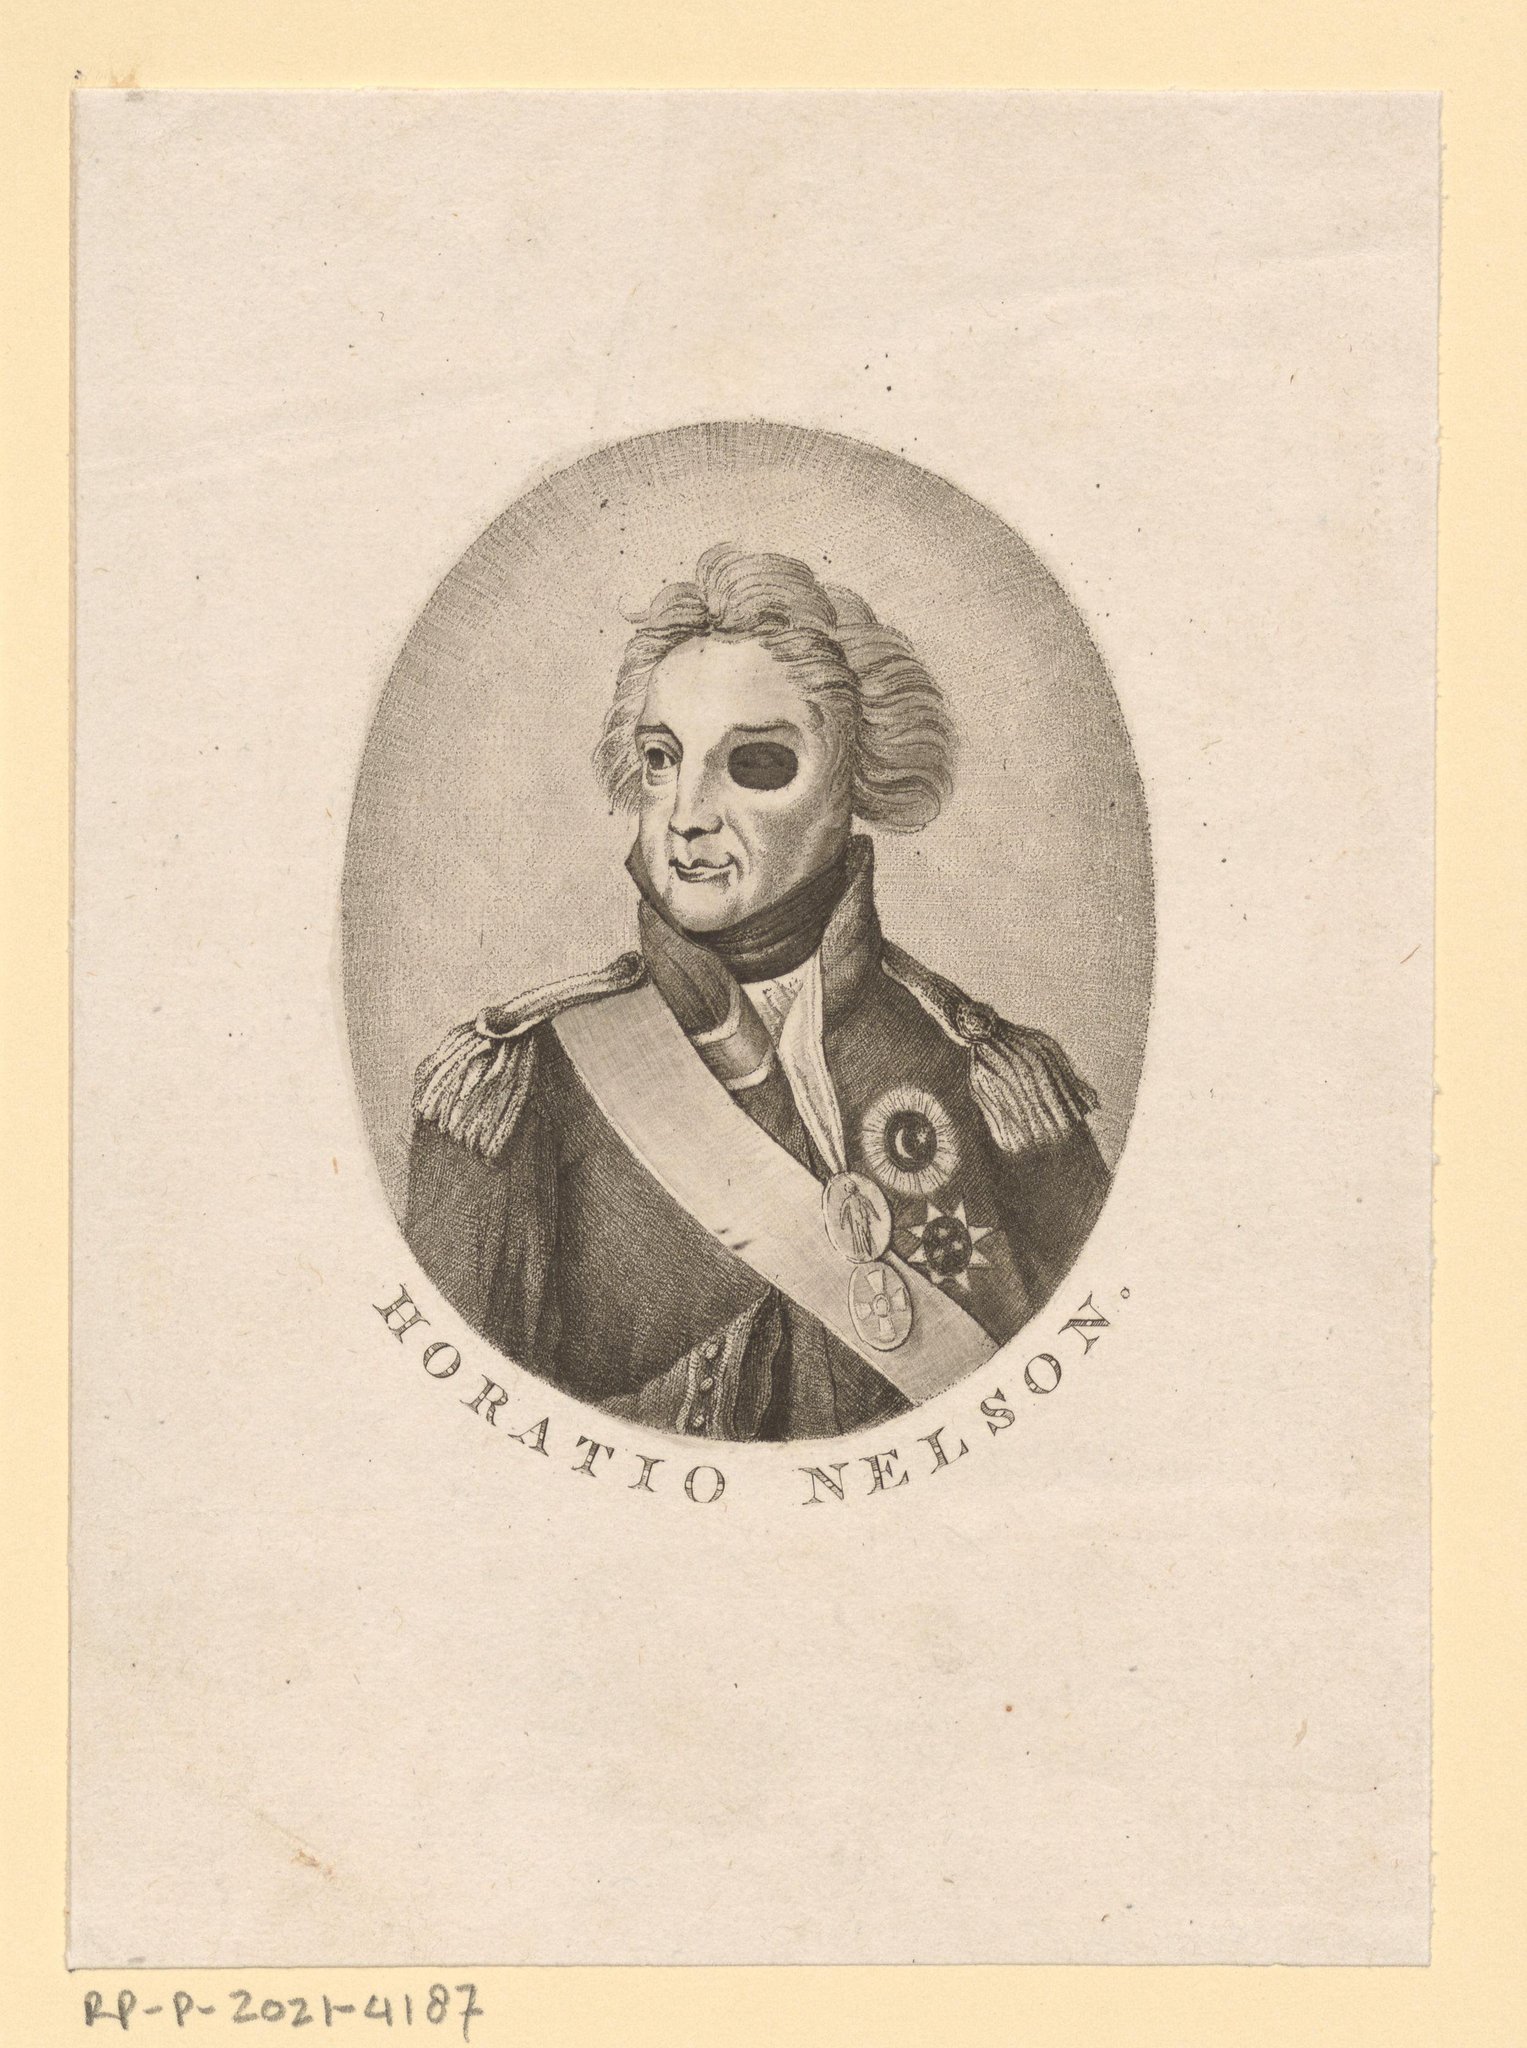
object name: print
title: Portret van Horatio Nelson, hertog van Bronte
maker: Anonymous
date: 1797-1849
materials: paper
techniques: etching, roulette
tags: horatio nelson (hertog van bronte), historical persons, commander-in-chief, admiral